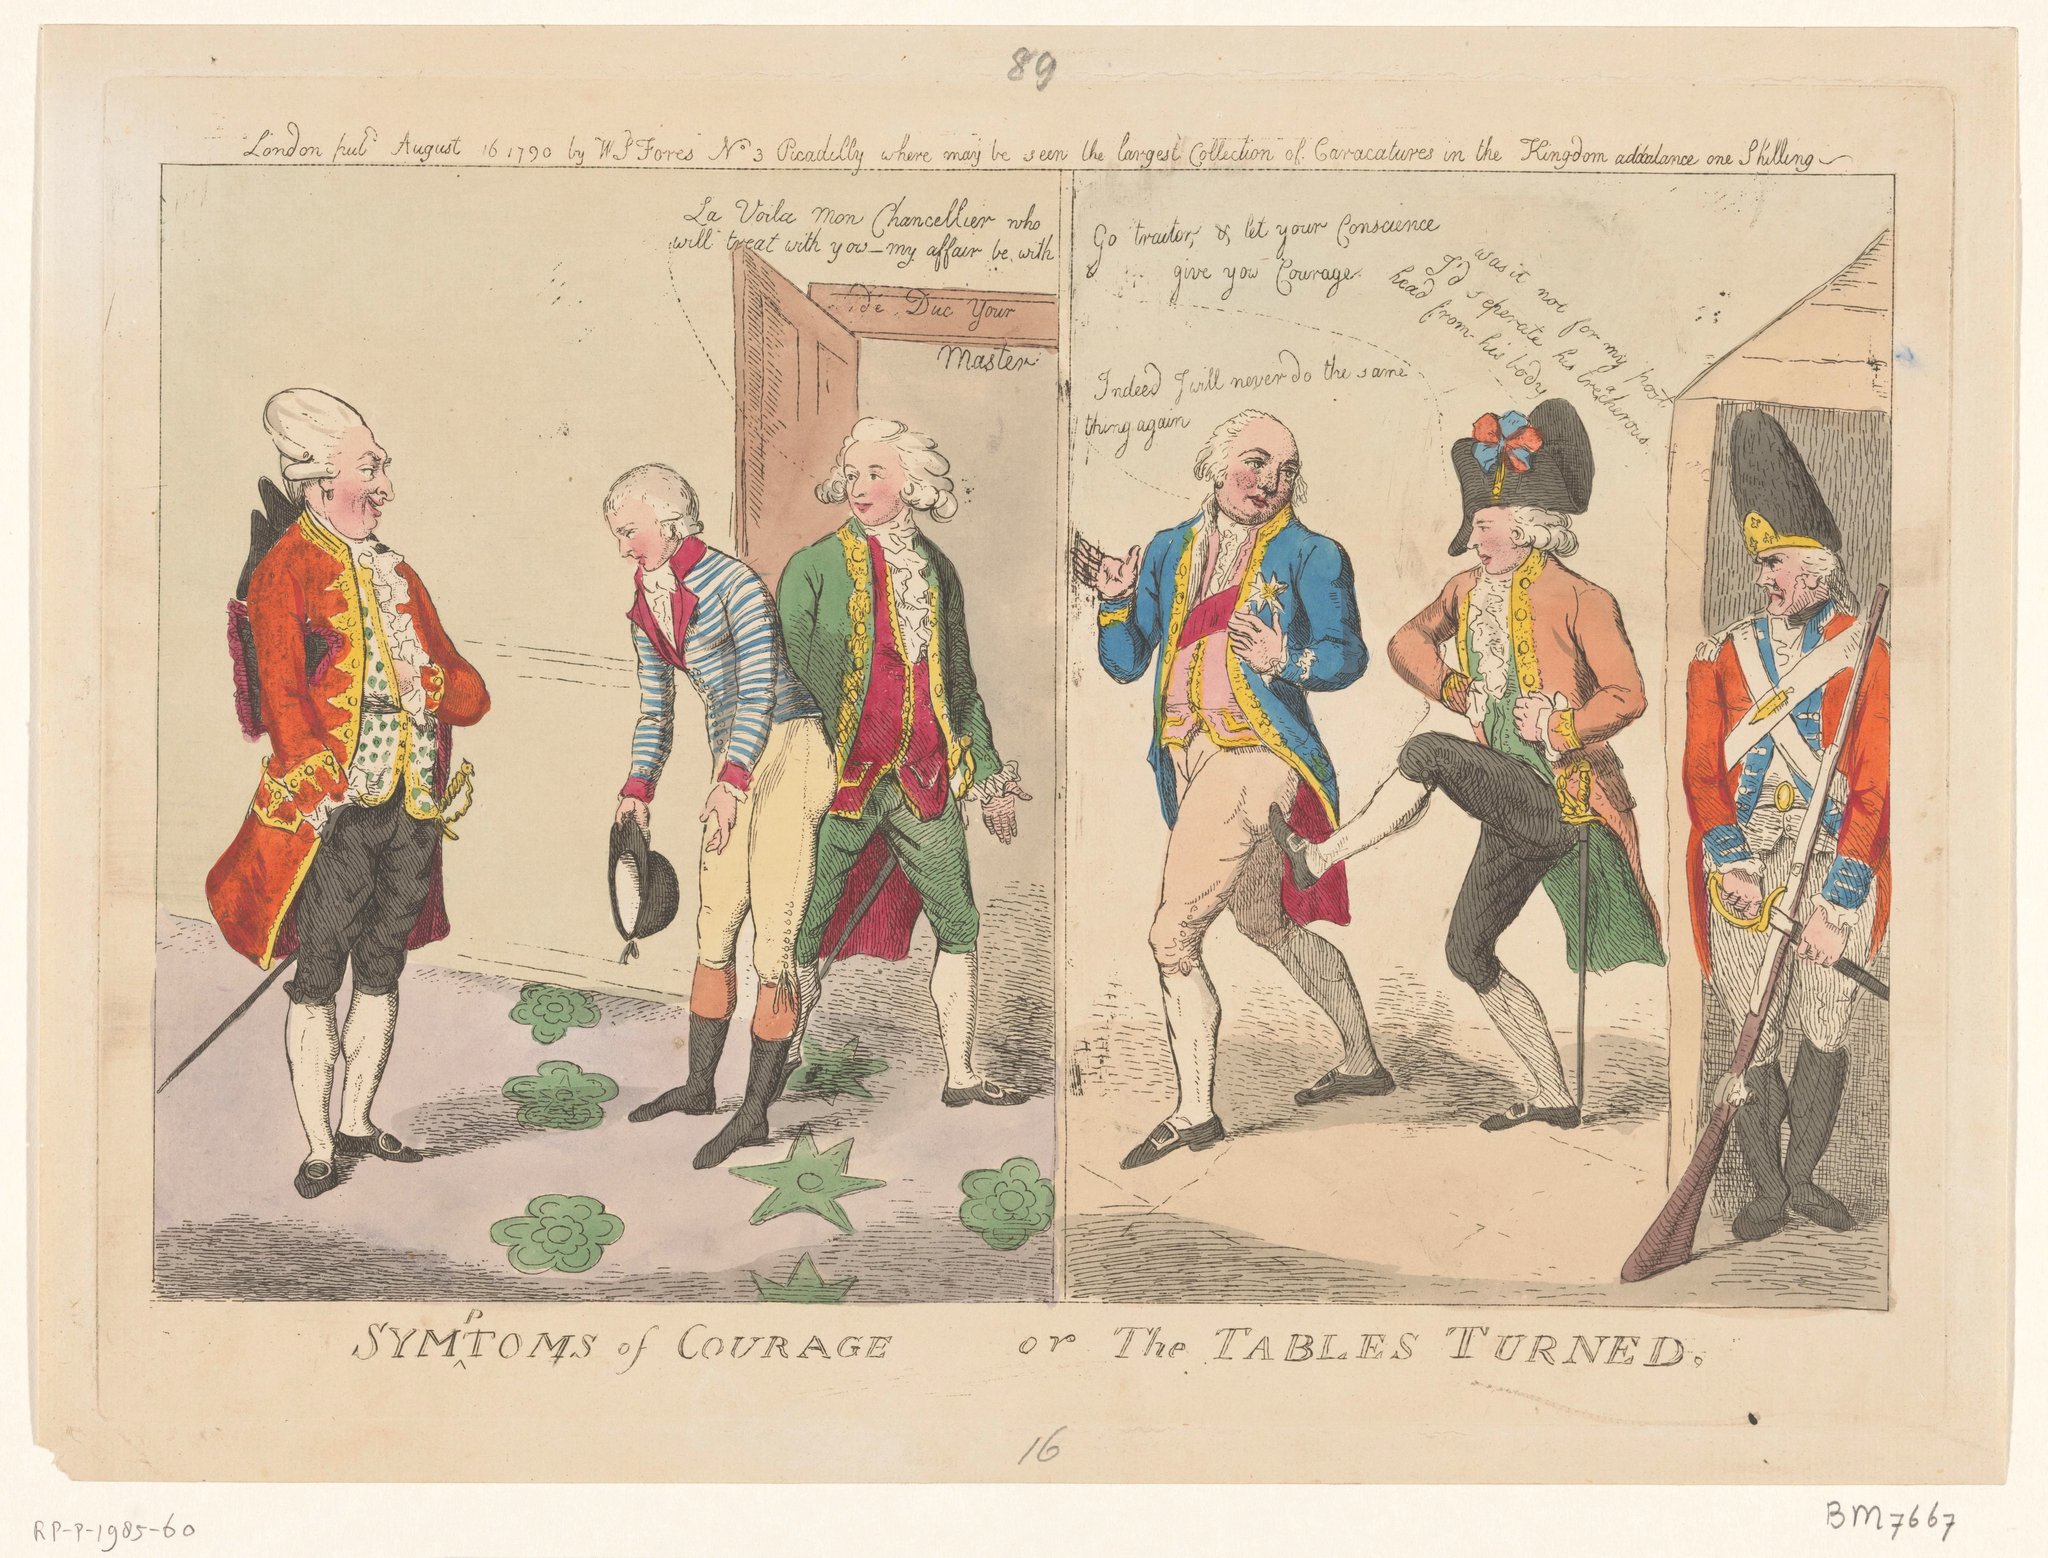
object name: print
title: Erezaak tussen De Voglas en de hertog van Orléans, 1790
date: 1790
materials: paper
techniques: etching, hand coloring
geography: london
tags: paris, lodewijk filips ii (hertog van orléans), military honours, quarrel, argument, political caricatures and satires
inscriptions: collector's mark: Lugt 2760, collector's mark: Lugt 2228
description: Spotprent in twee voorstellingen over een erezaak tussen De Voglas en de hertog van Orléans, 1790.